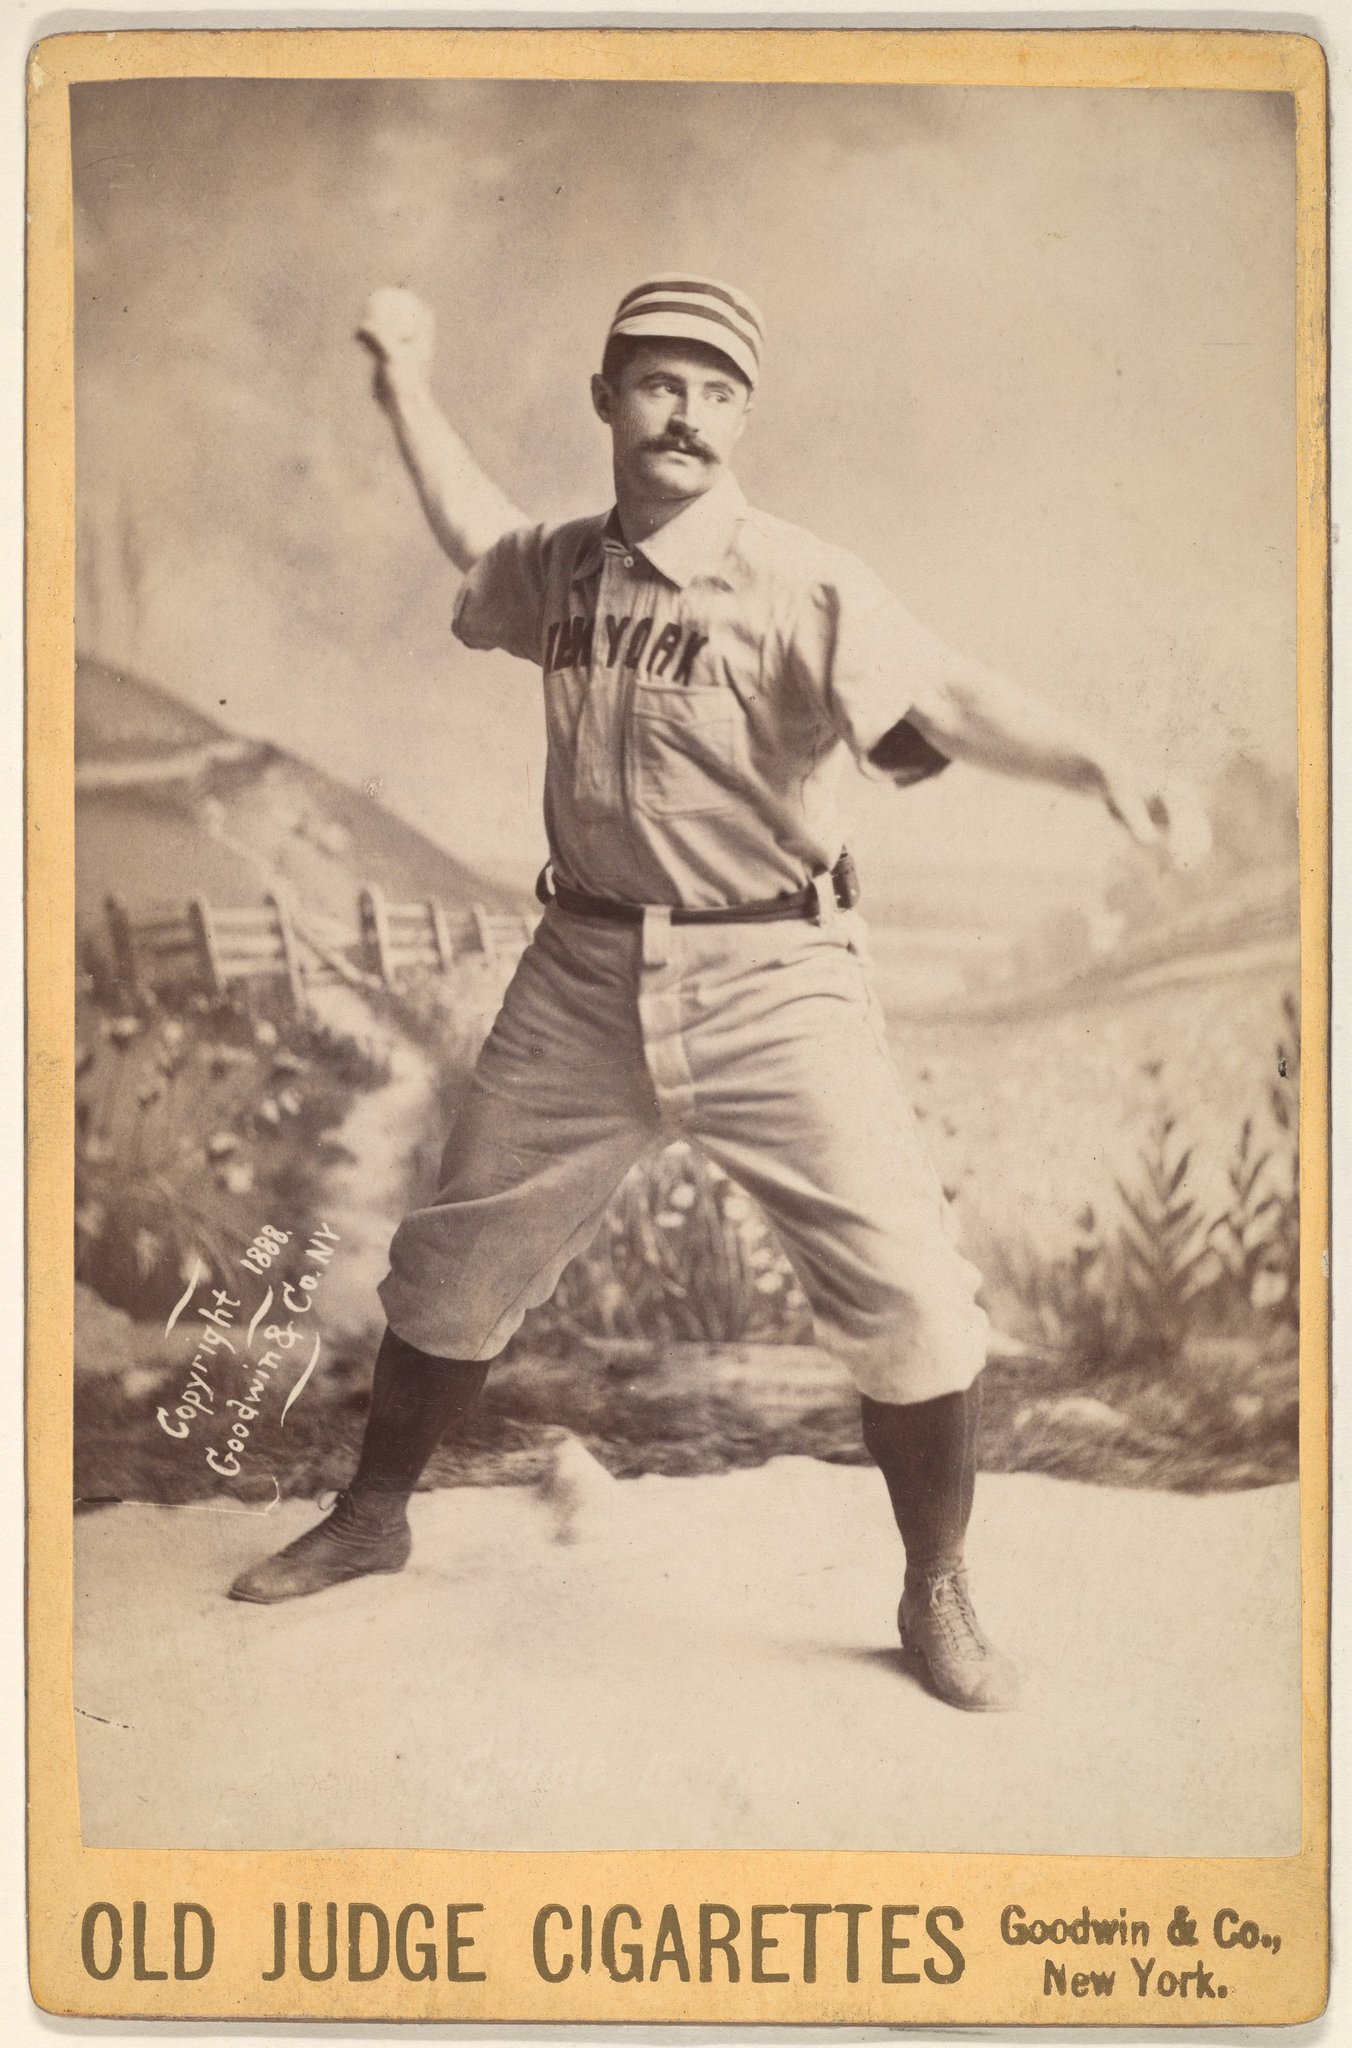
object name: baseball card, photograph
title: Crane, New York, from the series Old Judge Cigarettes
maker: goodwin & company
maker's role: publisher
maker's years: 1850-1950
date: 1888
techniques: albumen silver print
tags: men,portraits,baseball,athletes